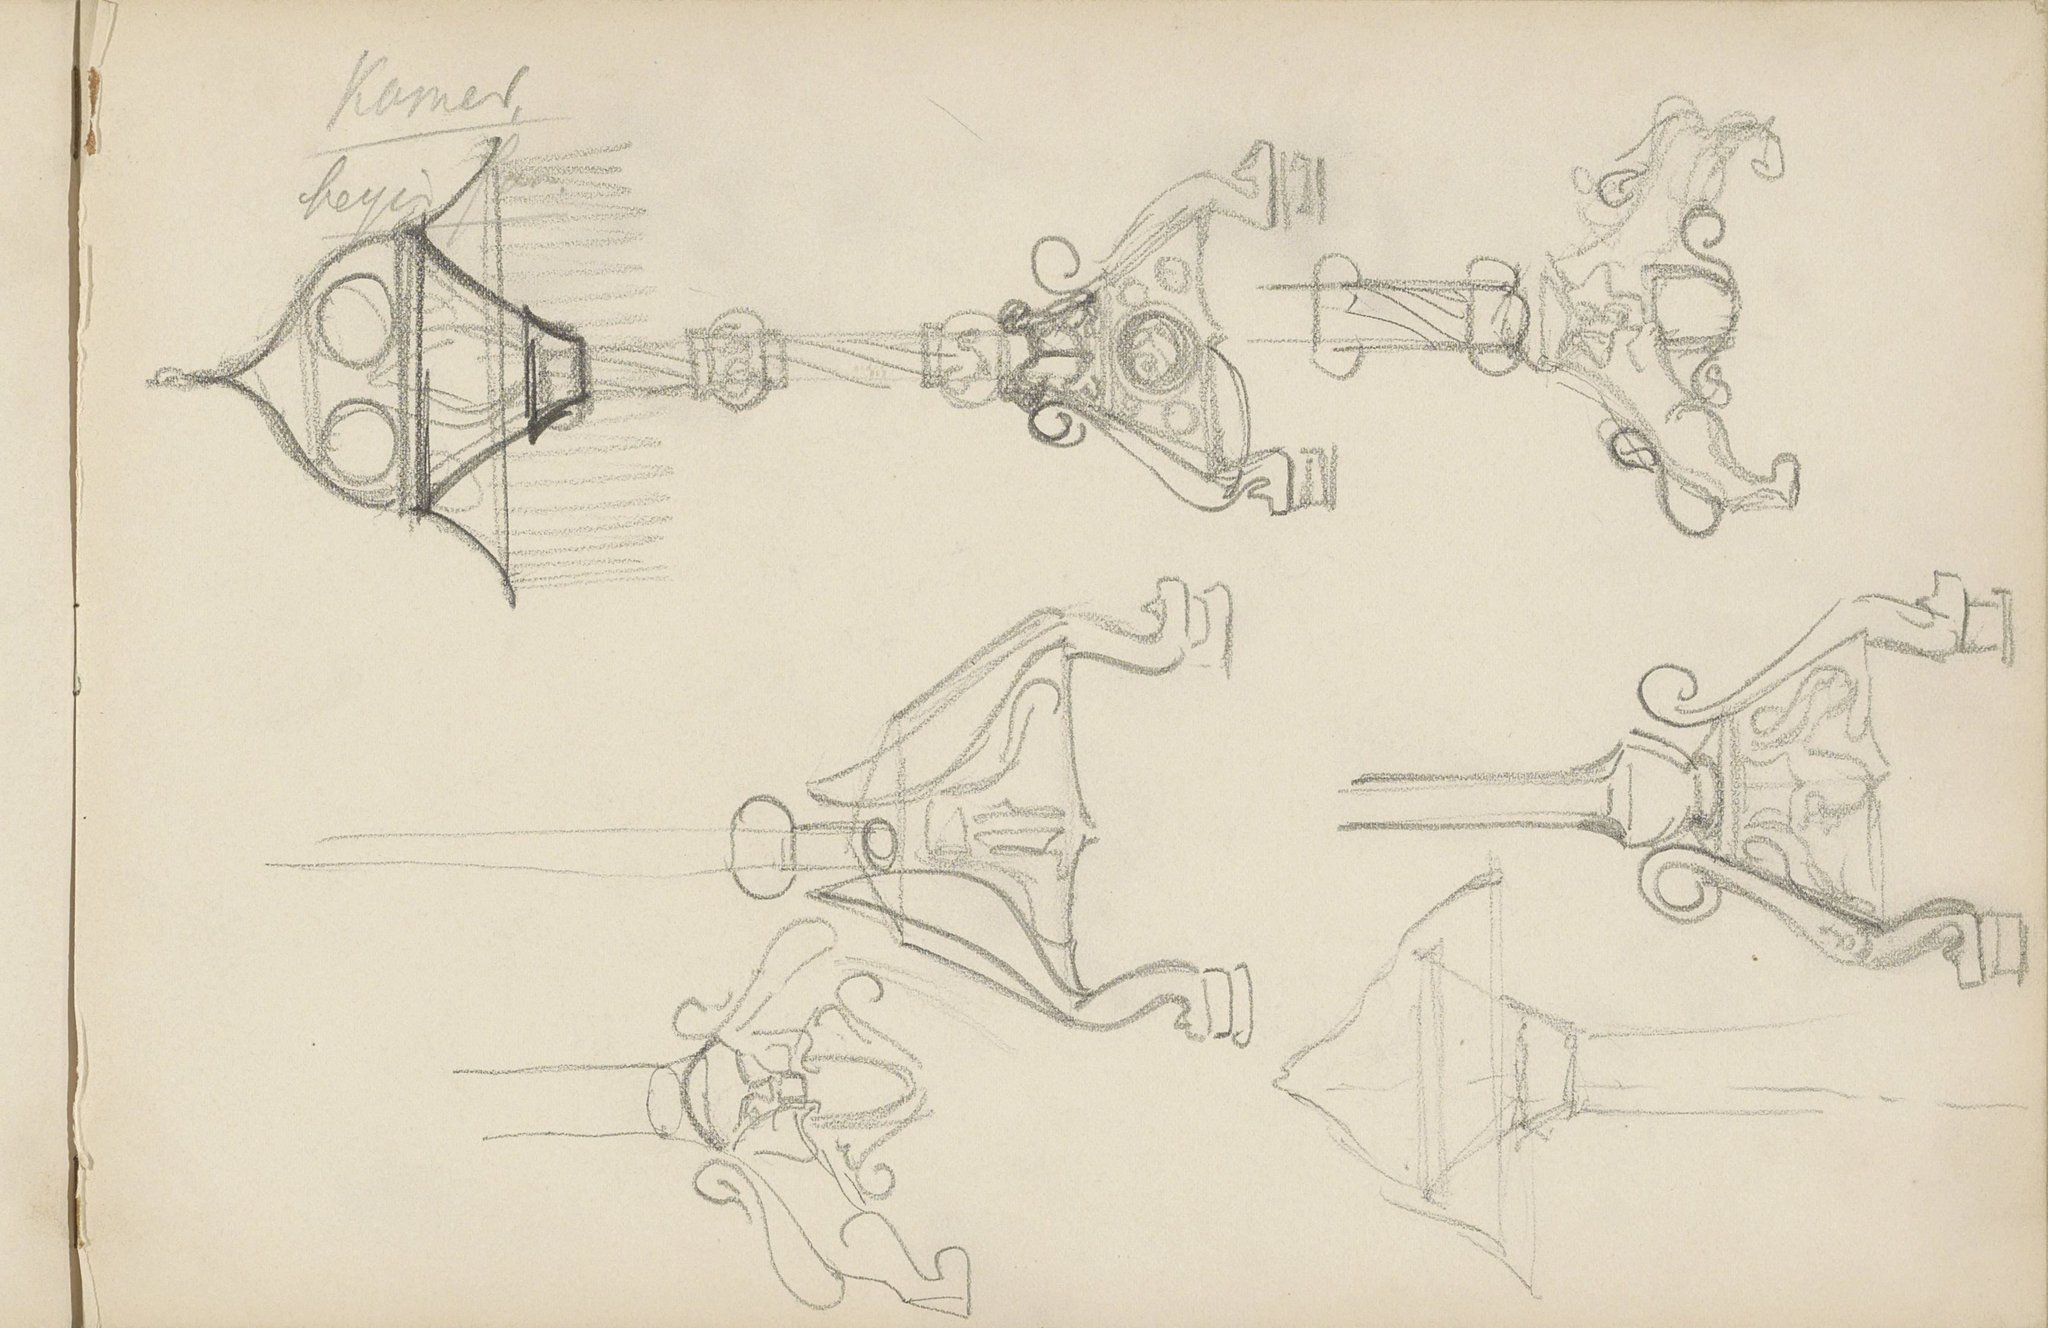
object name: sketchbook leaf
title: Staande lamp en ontwerpen voor lampenvoeten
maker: carel adolph lion cachet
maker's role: draughtsman, print maker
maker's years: 1864-1945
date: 1908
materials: paper, pencil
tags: lighting; lamps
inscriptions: annotation: ‘kamer/ beyer’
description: Blad 12 recto uit een schetsboek met 25 bladen.